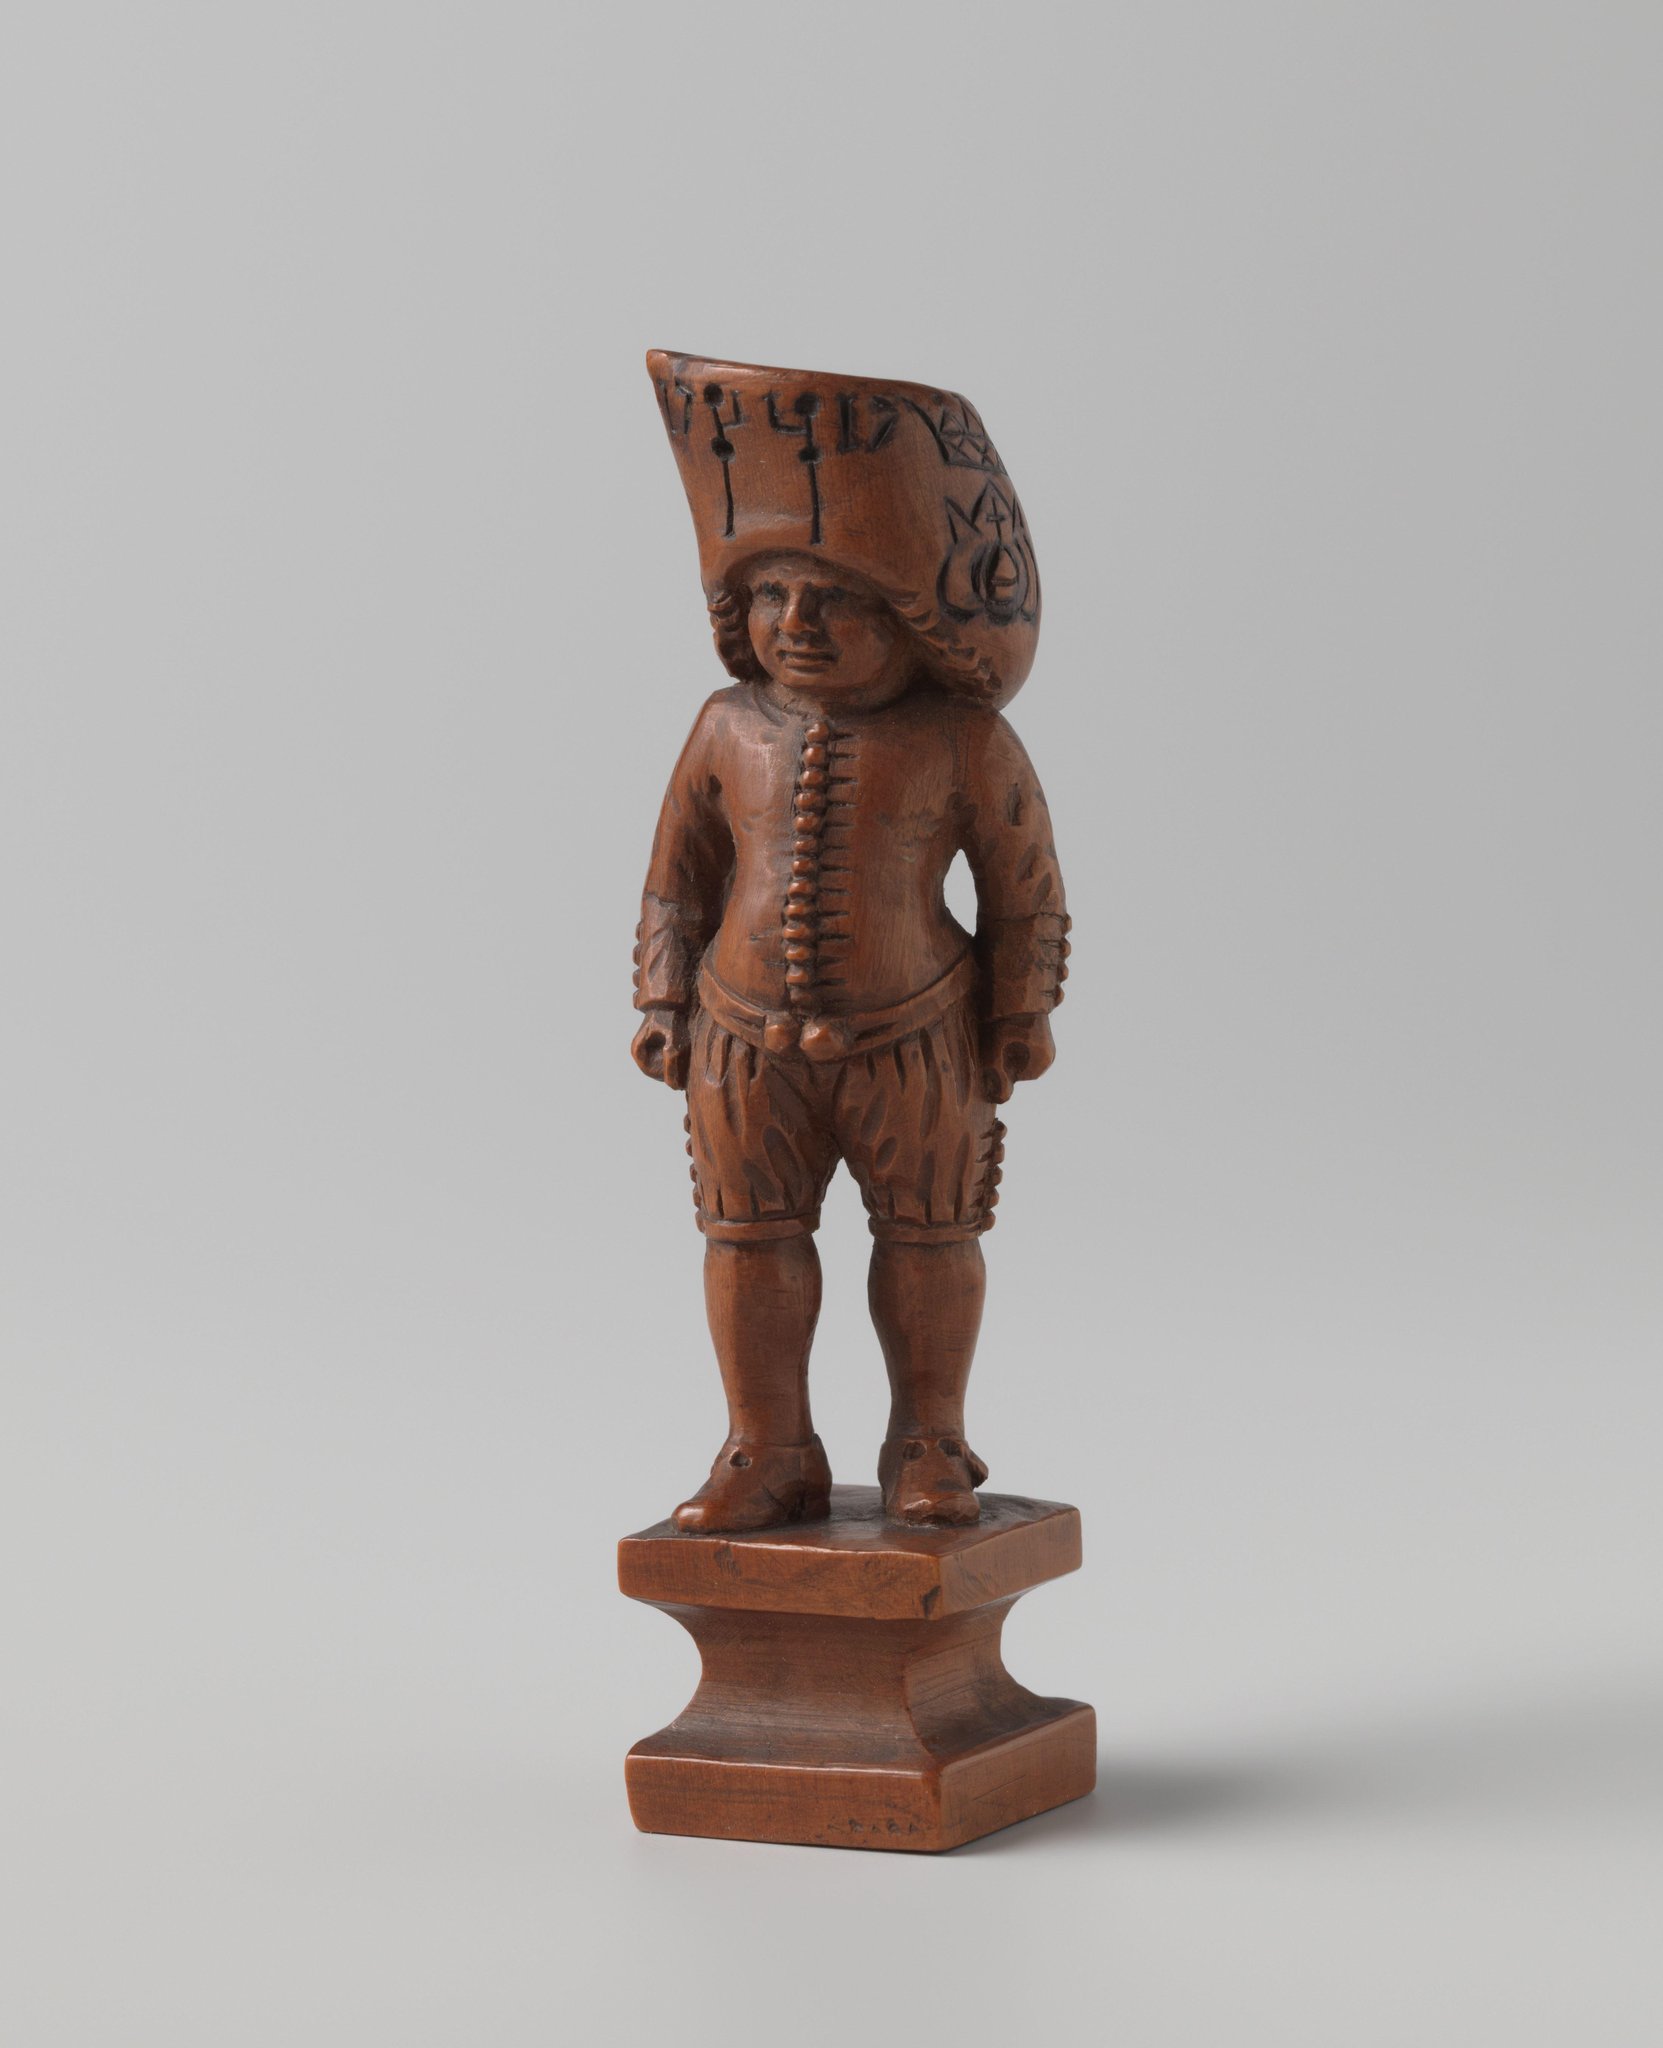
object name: sculpture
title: Corn-Carrier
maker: Anonymous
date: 1717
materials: wood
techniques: cutting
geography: northern netherlands